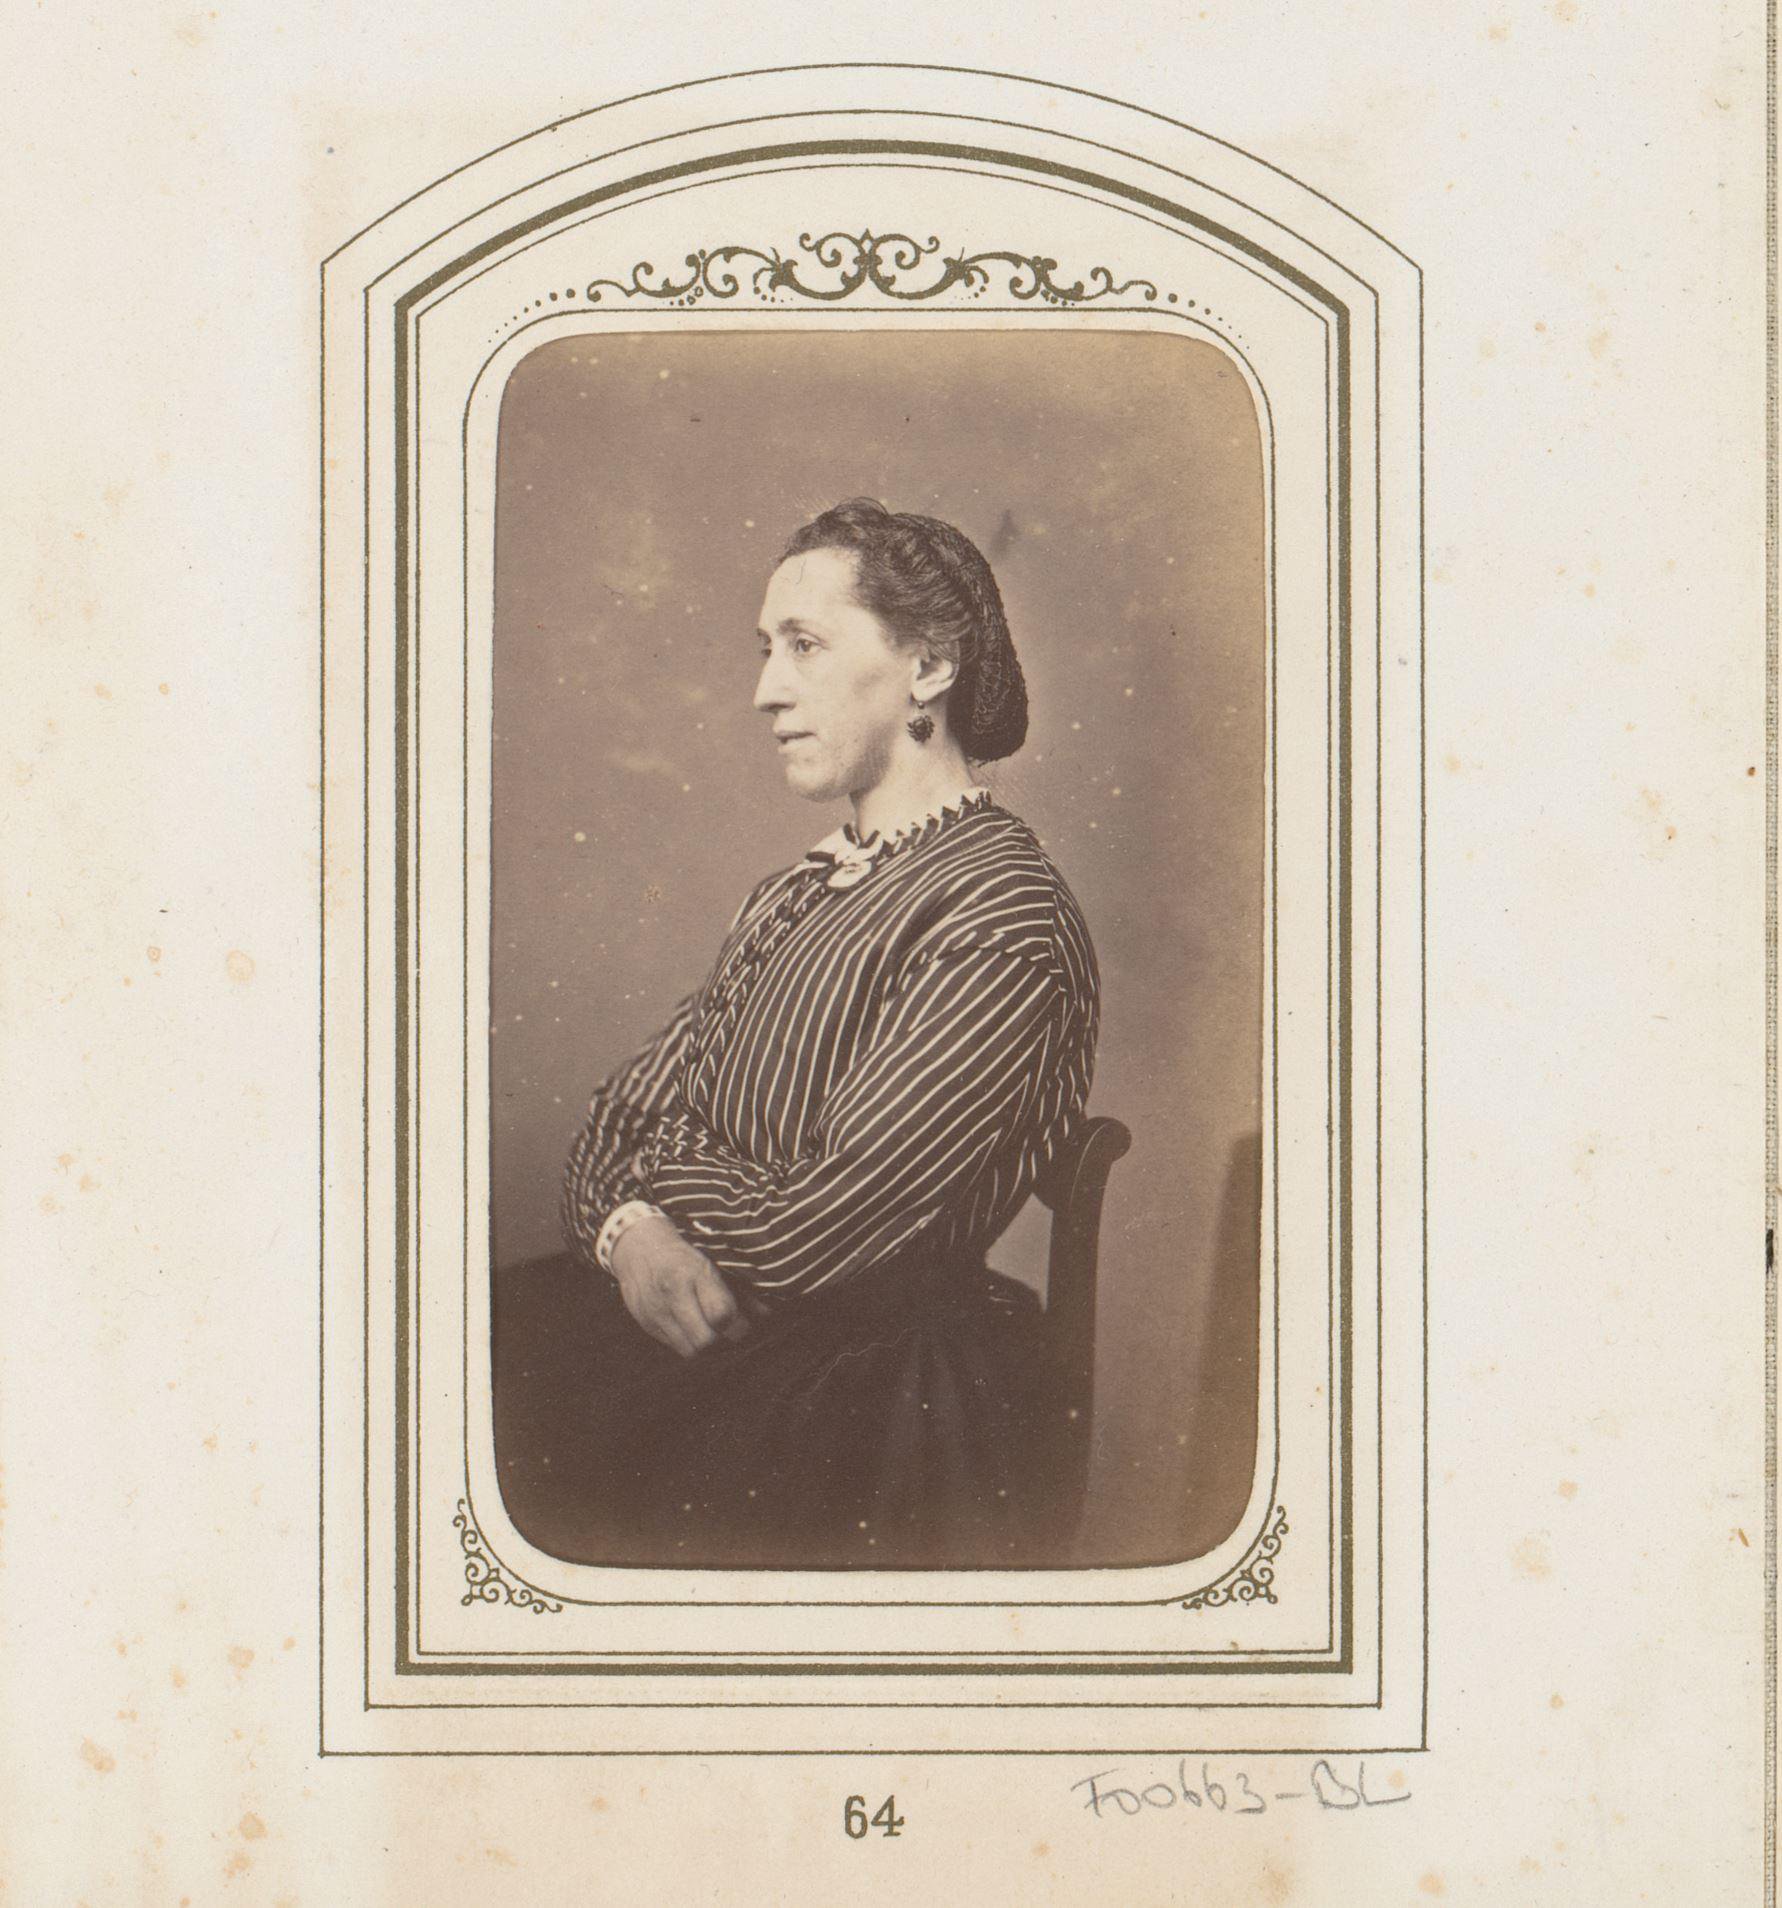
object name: carte de visite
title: Portret van een zittende vrouw, en profil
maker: roelof loots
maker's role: fotograaf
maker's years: 1814-1898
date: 1860-1880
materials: cardboard, photographic support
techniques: albumen print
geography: medemblik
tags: historical persons - bb - woman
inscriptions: inscription: ‘Photographie/ R. Loots/ Medemblik’, number: ‘64’